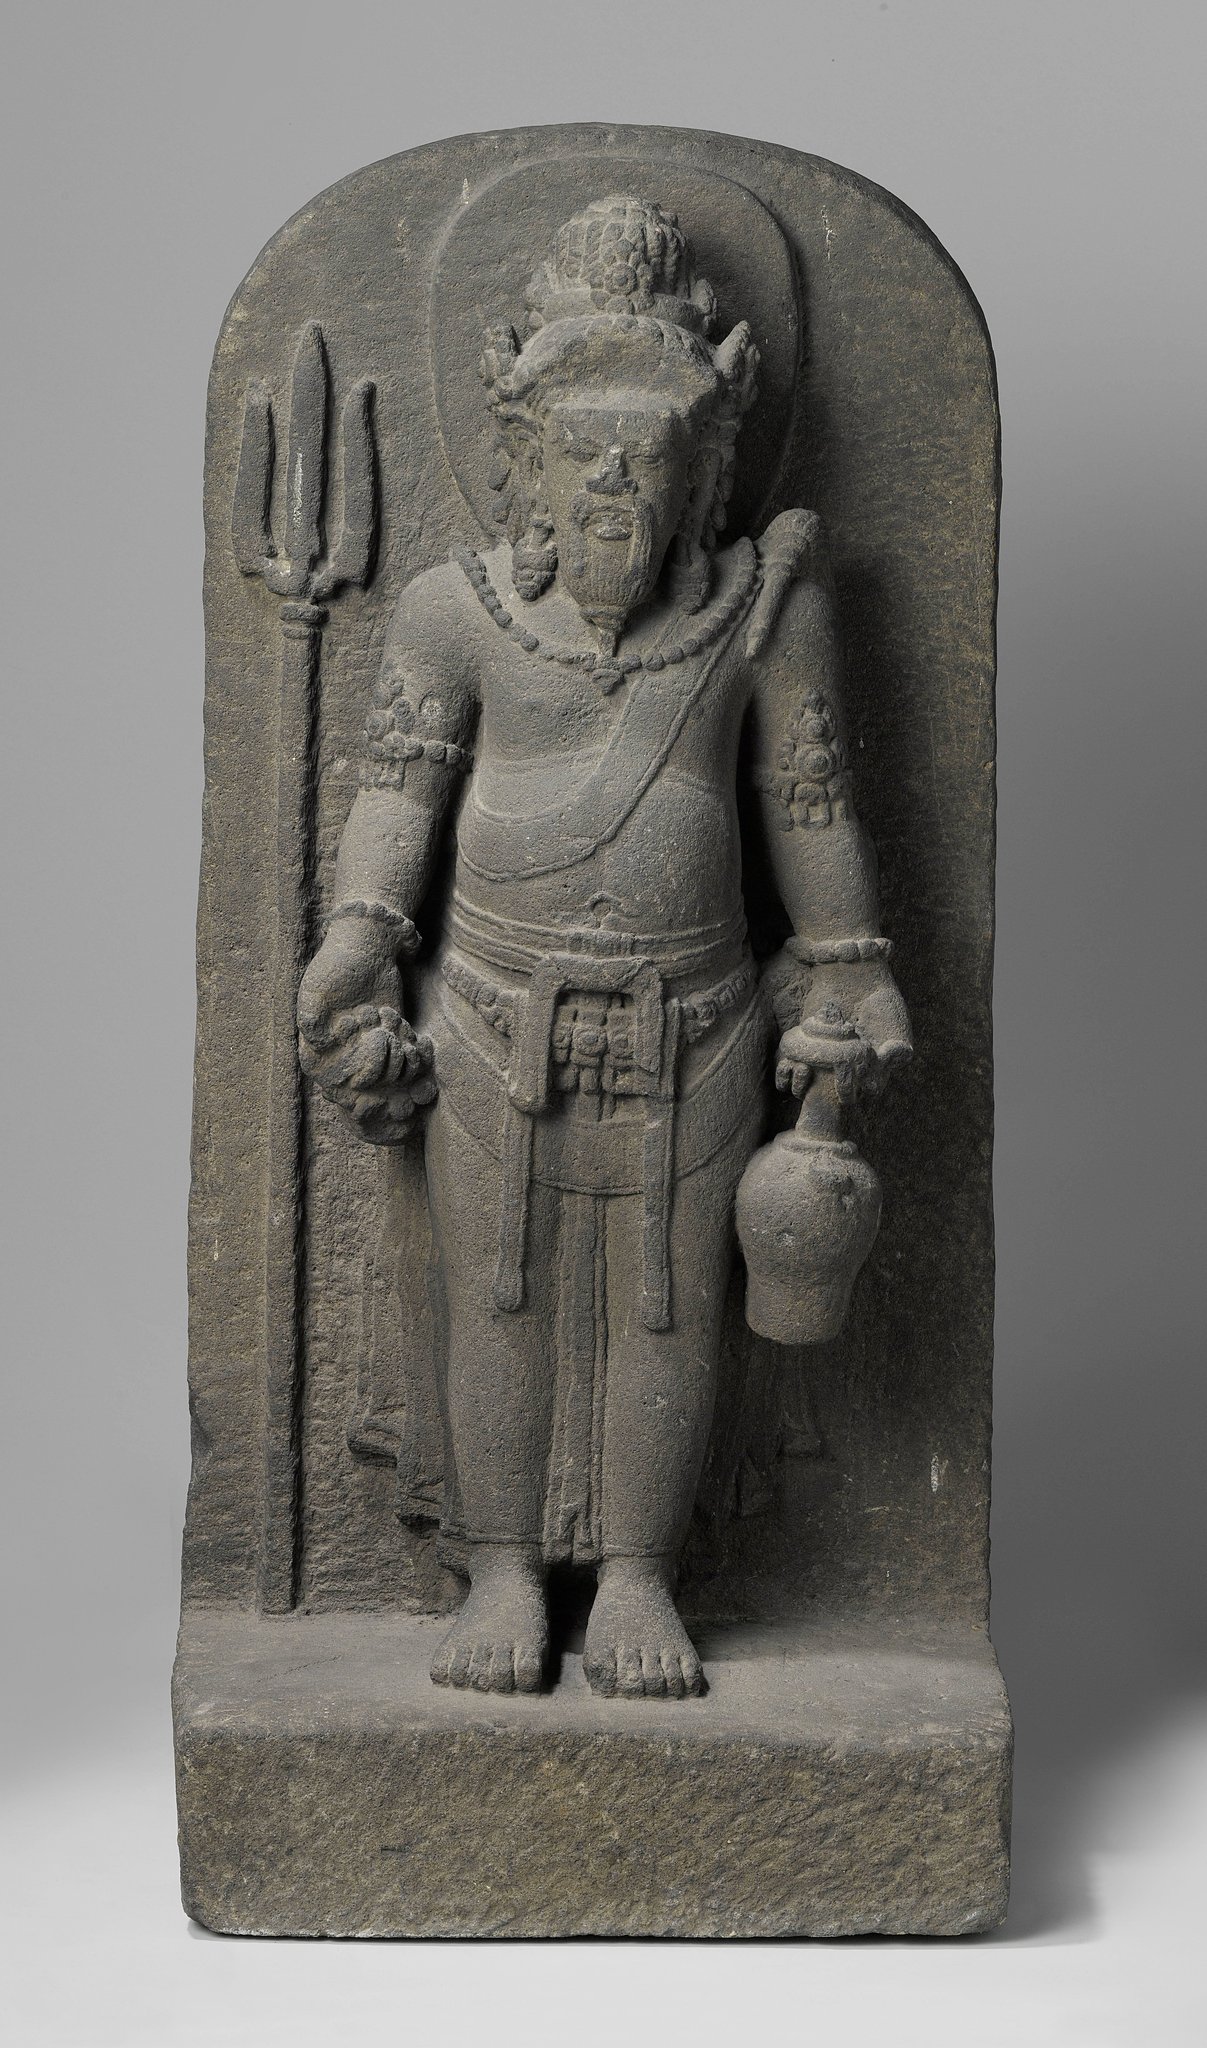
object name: sculpture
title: Shiva Guru (Agastya)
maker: Anonymous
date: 800-930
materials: stone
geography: central java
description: A guru or religious teacher serves a god by spreading his doctrine among the people. This particular guru is a servant of Shiva, as is clear from the trident (Shiva’s weapon). He is carrying a string of prayer beads and a water jar, essential for periods of retreat and contemplation. Such figures often stood in a niche on the south side of Shiva temples.